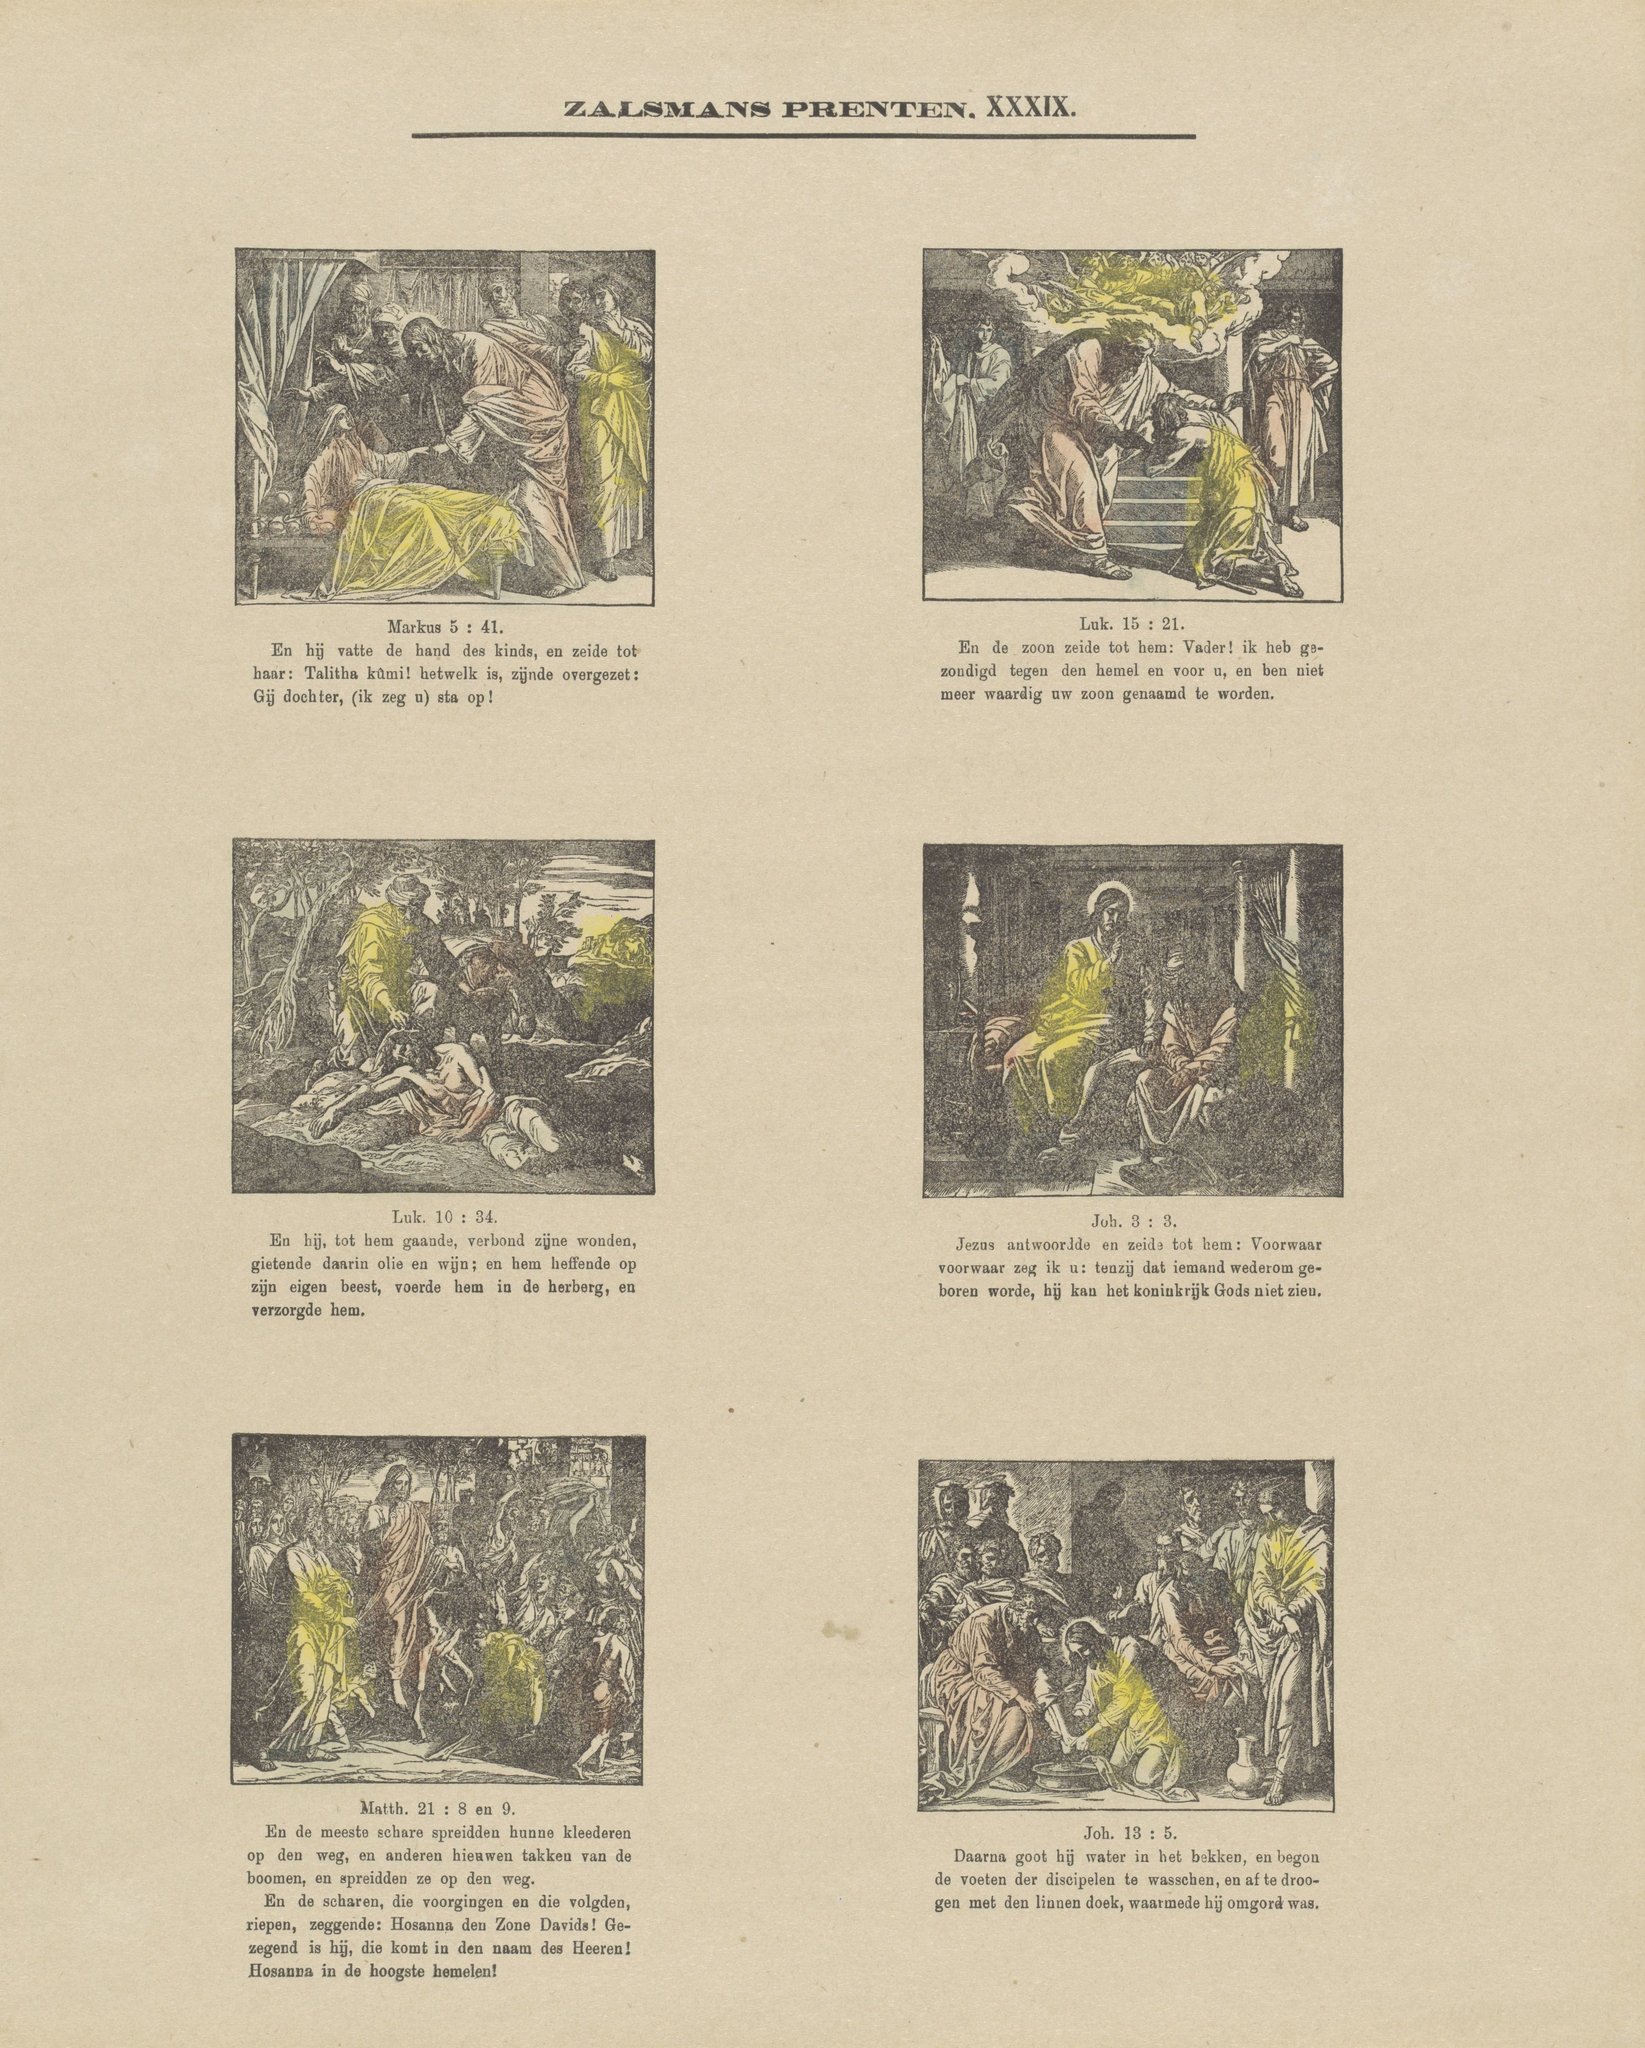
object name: print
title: Leven van Christus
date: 1869-1882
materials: paper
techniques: colour, letterpress printing, engraving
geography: kampen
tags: new testament, series of scenes from the life of christ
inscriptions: collector's mark: Lugt 2760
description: Blad met 6 voorstellingen van verhalen uit het Nieuwe Testament over het leven van Christus. Onder elke afbeelding een onderschrift en een verwijzing naar de bijbehorende Bijbeltekst. Genummerd midden boven: XXXIX.